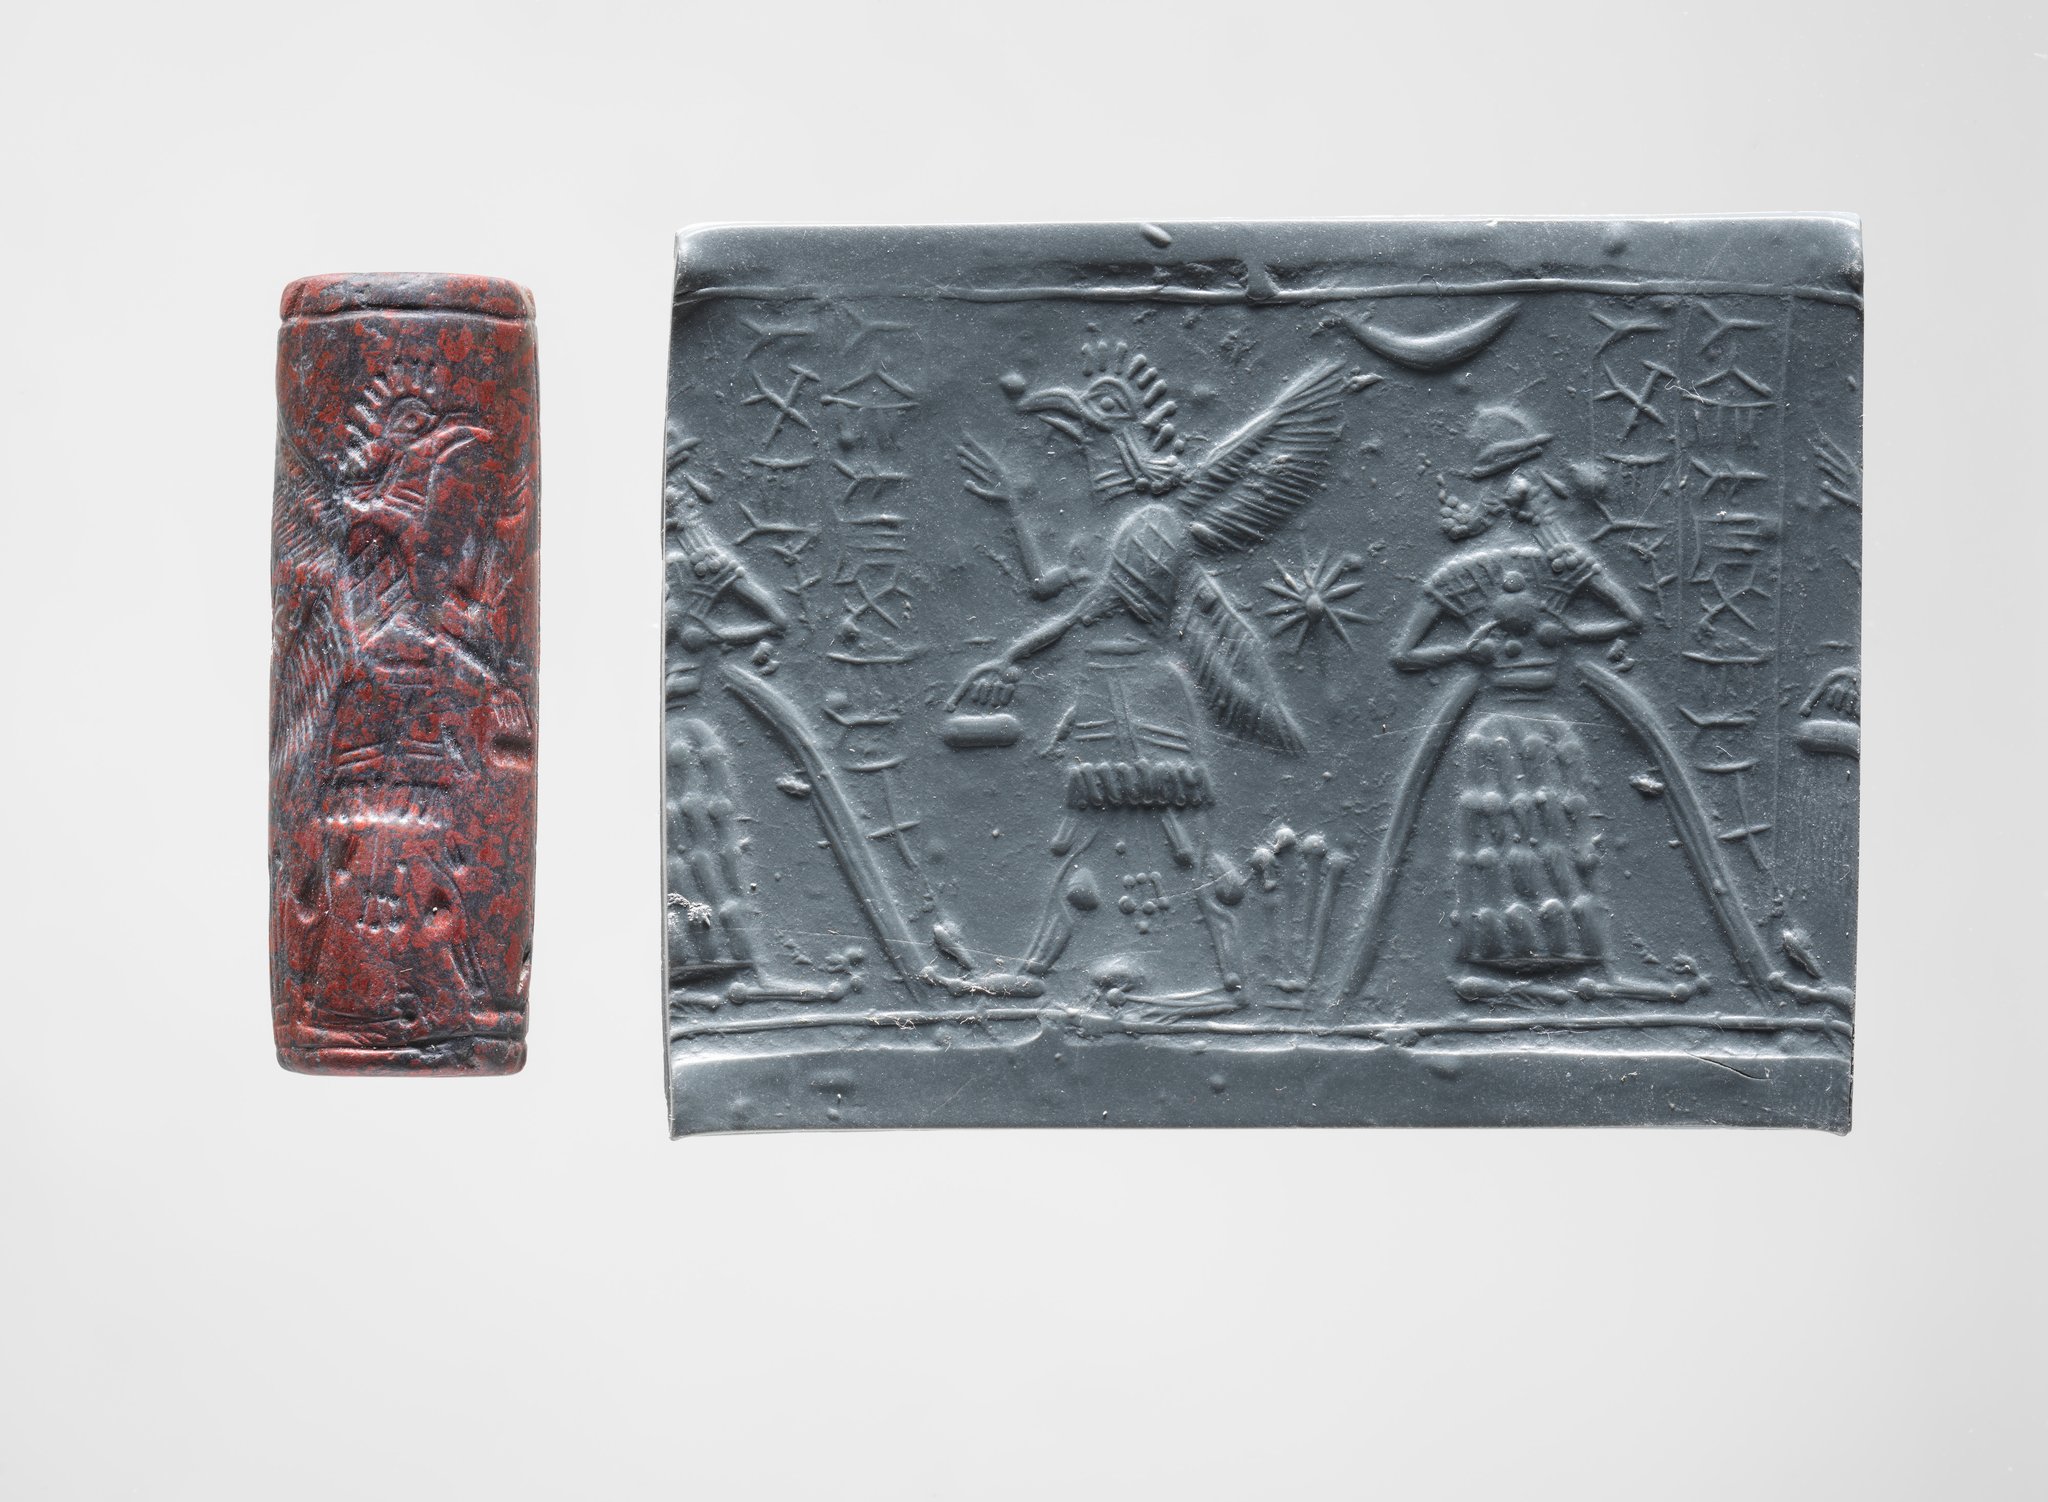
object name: cylinder seal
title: Cylinder seal and modern impression: god with flowing vase; griffin demon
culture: assyrian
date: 1200-1101 BCE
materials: jasper, marble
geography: mesopotamia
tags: griffins,gods,vases